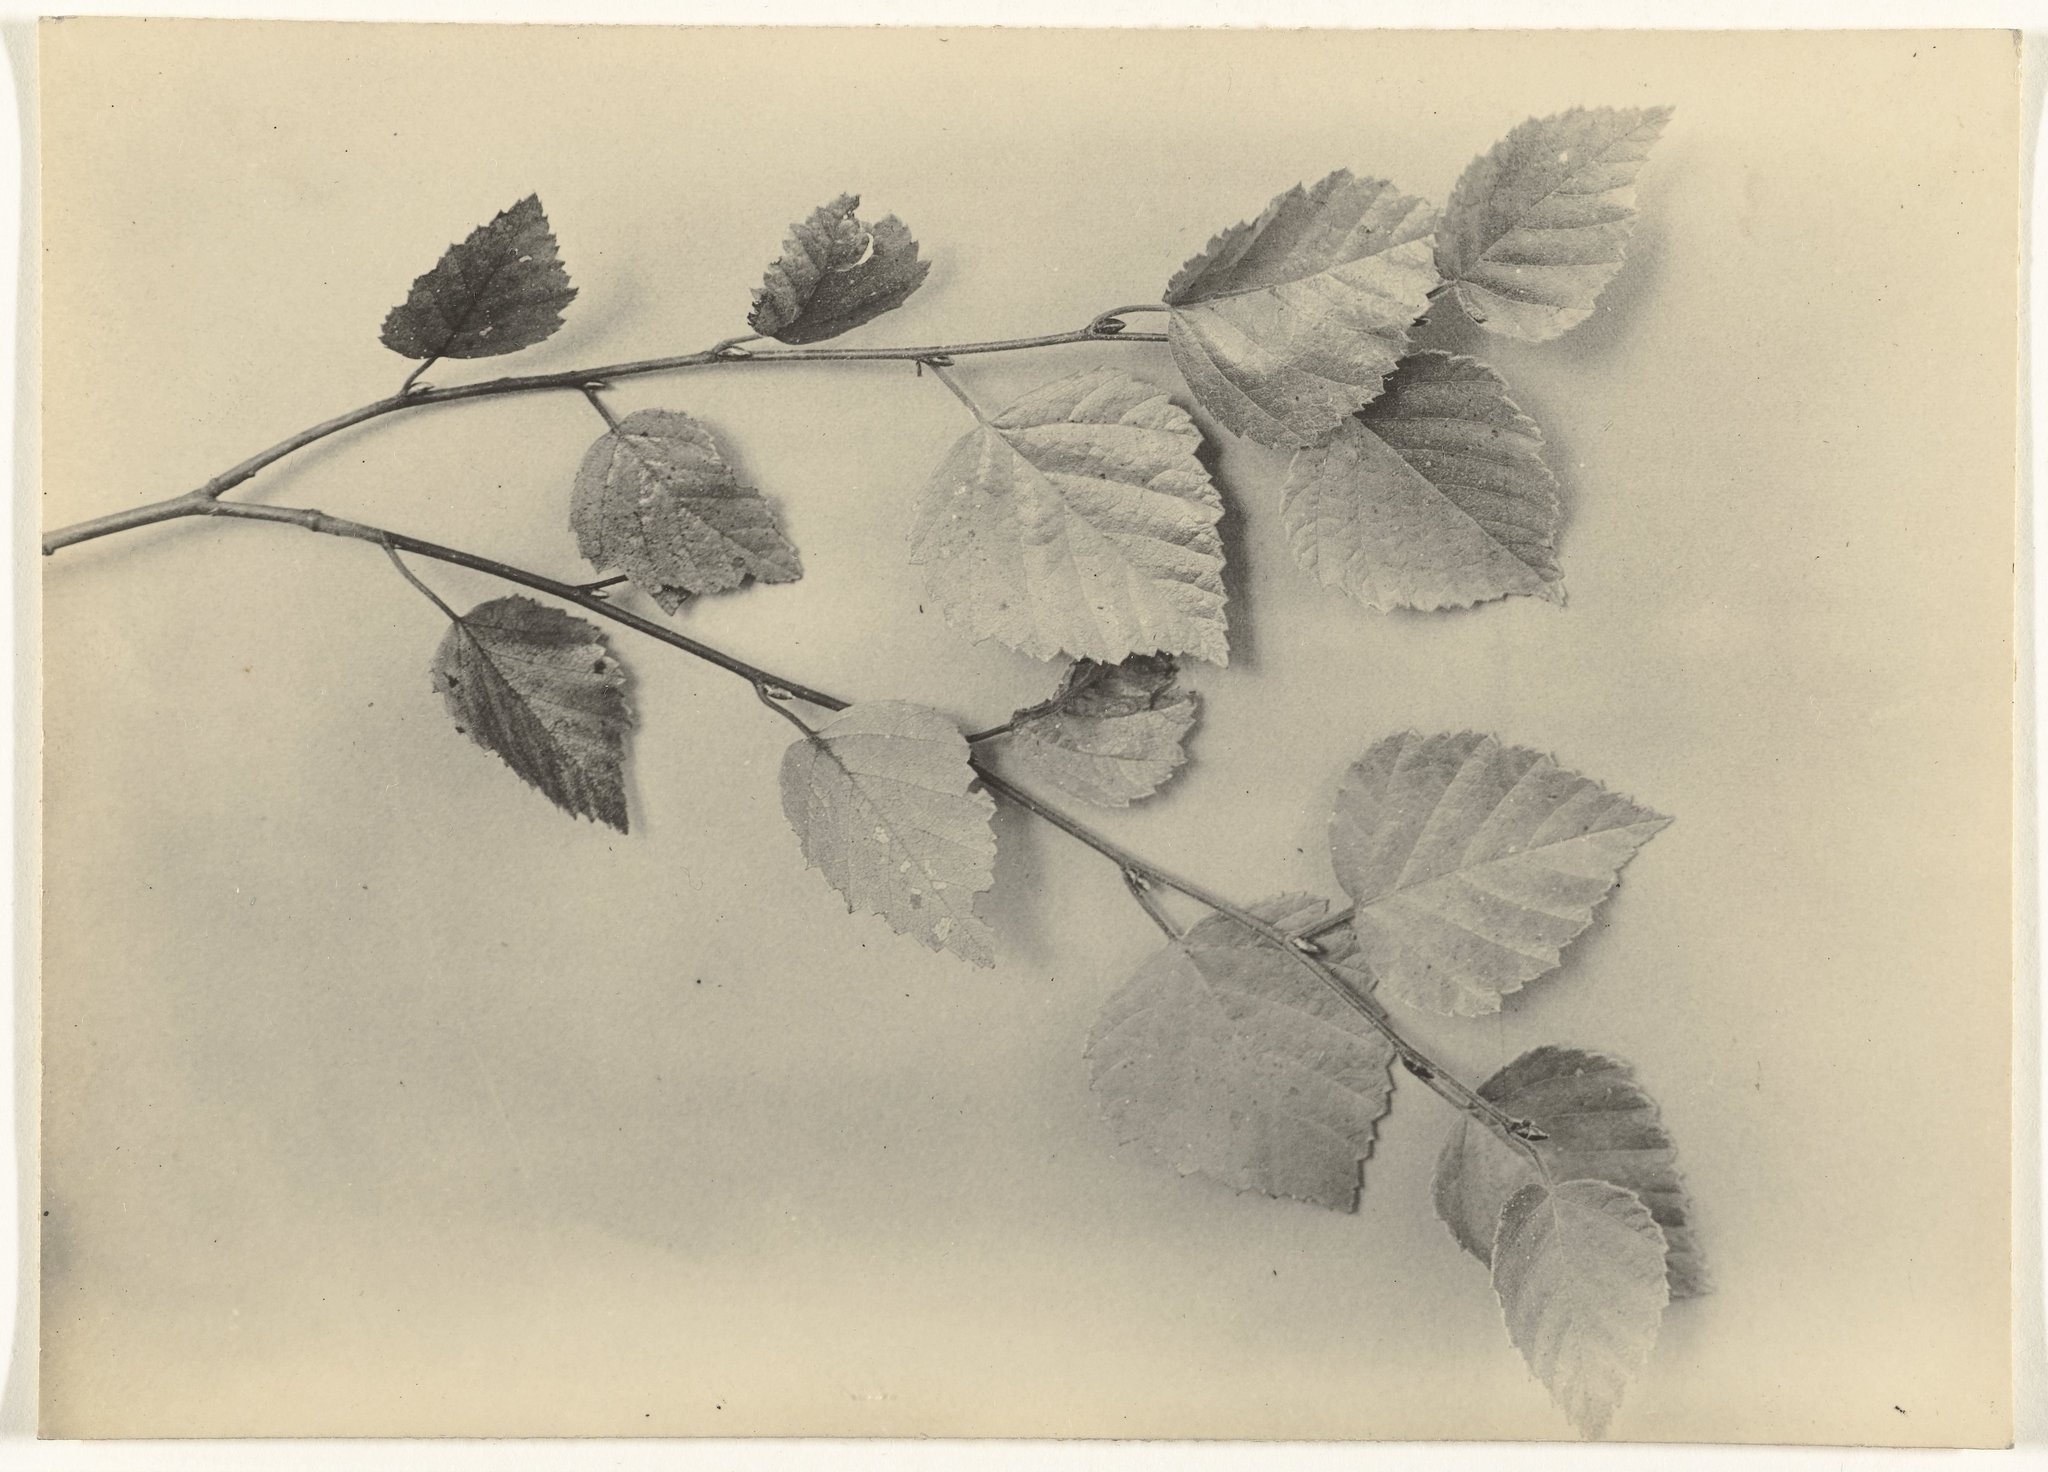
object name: photograph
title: Tak met bladeren van een zachte berk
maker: richard tepe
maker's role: fotograaf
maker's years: 1864-1952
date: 1900-1930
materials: photographic support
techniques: gelatin silver print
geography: netherlands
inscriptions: annotation: ‘Bovenzyde / Bladerentak van den / Zachten Berk / Betula pubescens’, signature: ‘foto / R Tepe’